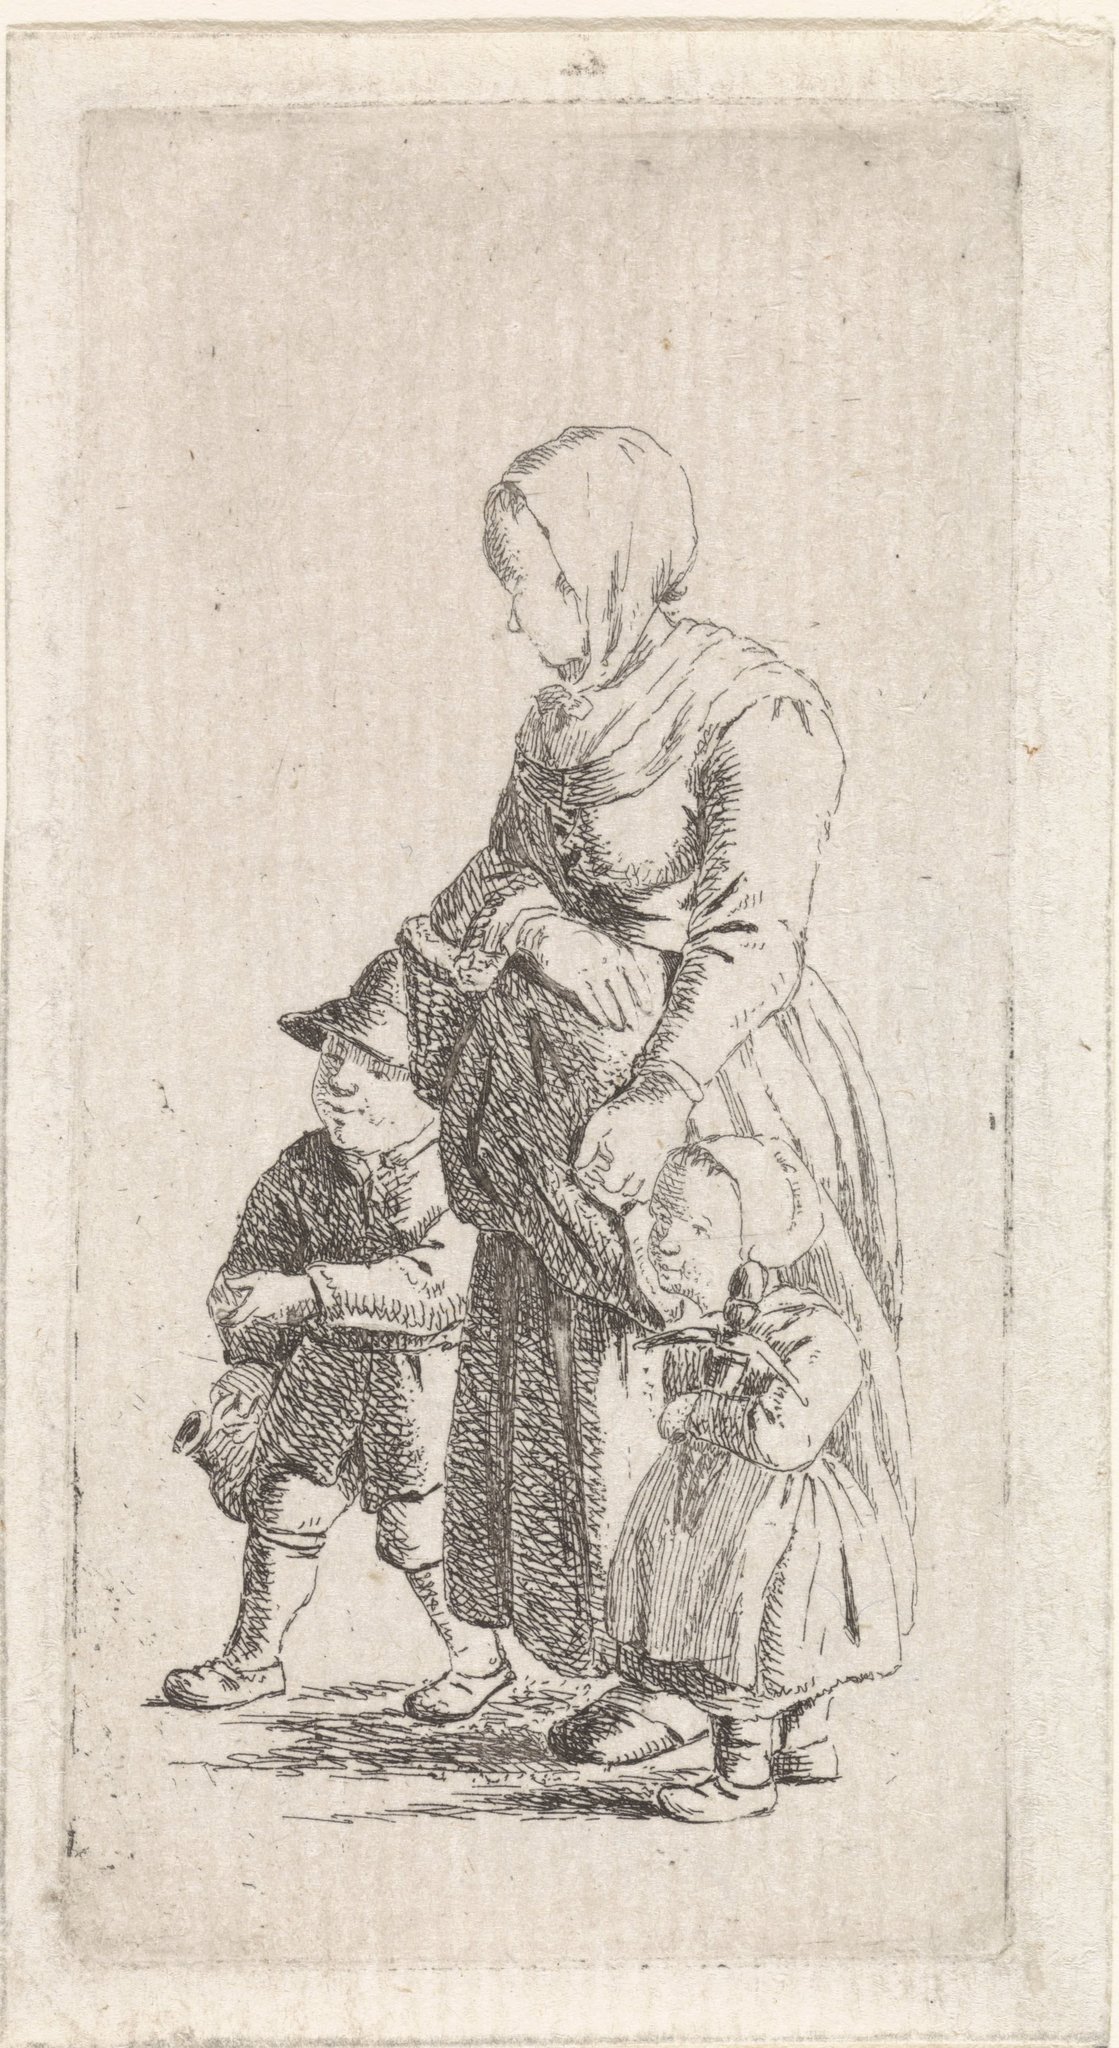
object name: print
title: Vrouw met twee kinderen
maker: johannes christiaan janson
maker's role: draughtsman, painter, print maker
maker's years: 1763-1823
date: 1778-1823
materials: paper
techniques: etching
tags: mother and child(ren), woman and child(ren) (family group) (with number of children)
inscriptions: collector's mark: Lugt 2228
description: Vrouw met mand, lopend naar links. Rechts naar haar loopt een jongen met een kan in zijn rechterhand. Met haar linkerhand houdt ze de hand van een meisje vast. Het meisje heeft een pop vast. Prent uit een serie met vrouwen en kinderen.